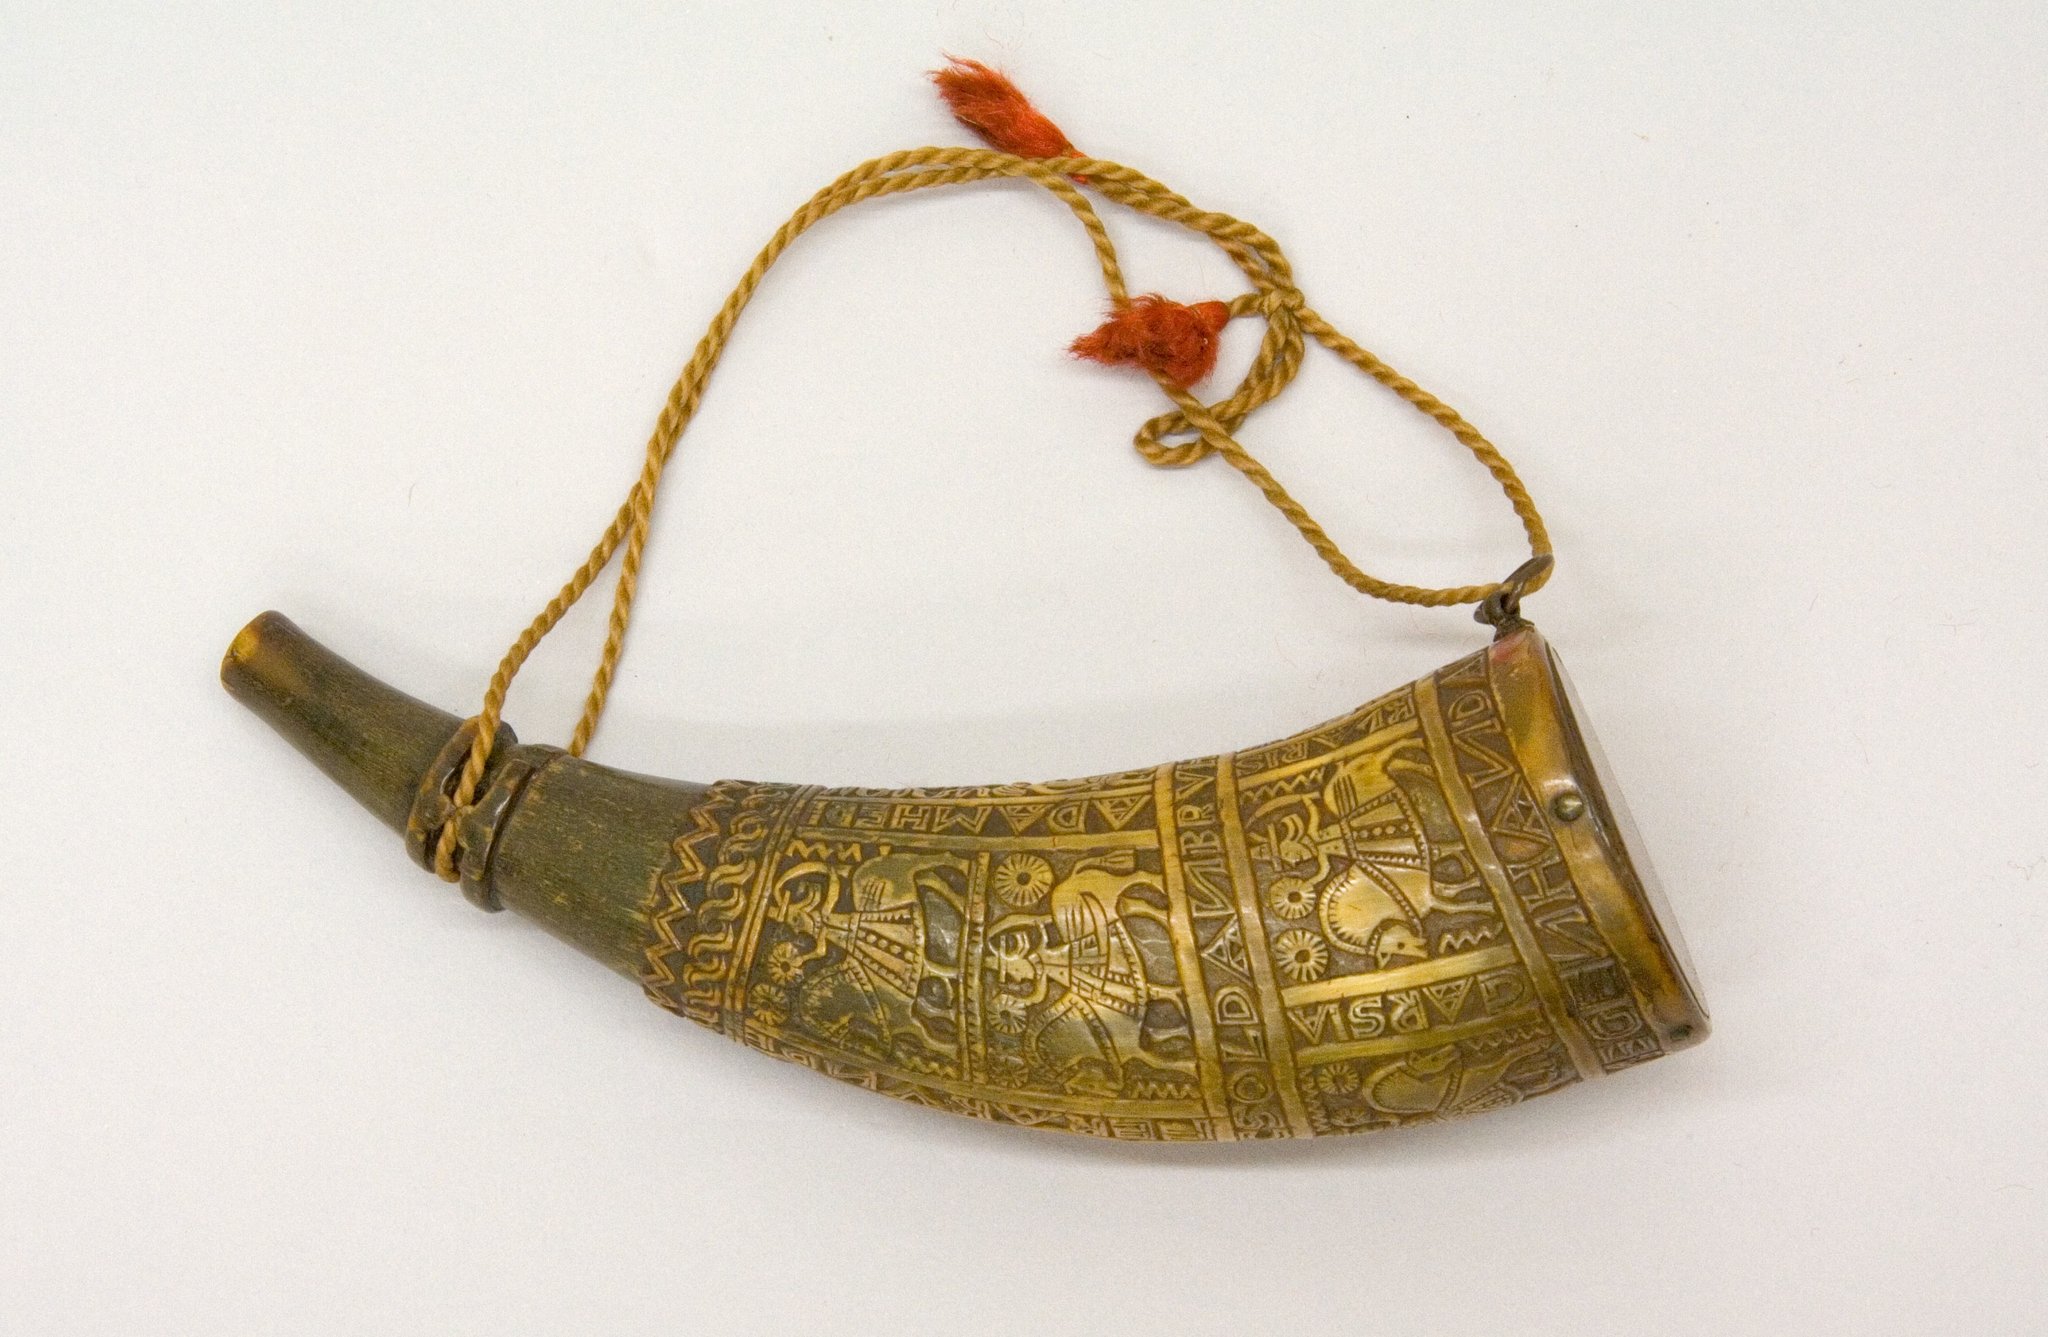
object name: powder flask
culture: norwegian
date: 1698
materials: brass, cord, horn, wood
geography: norway